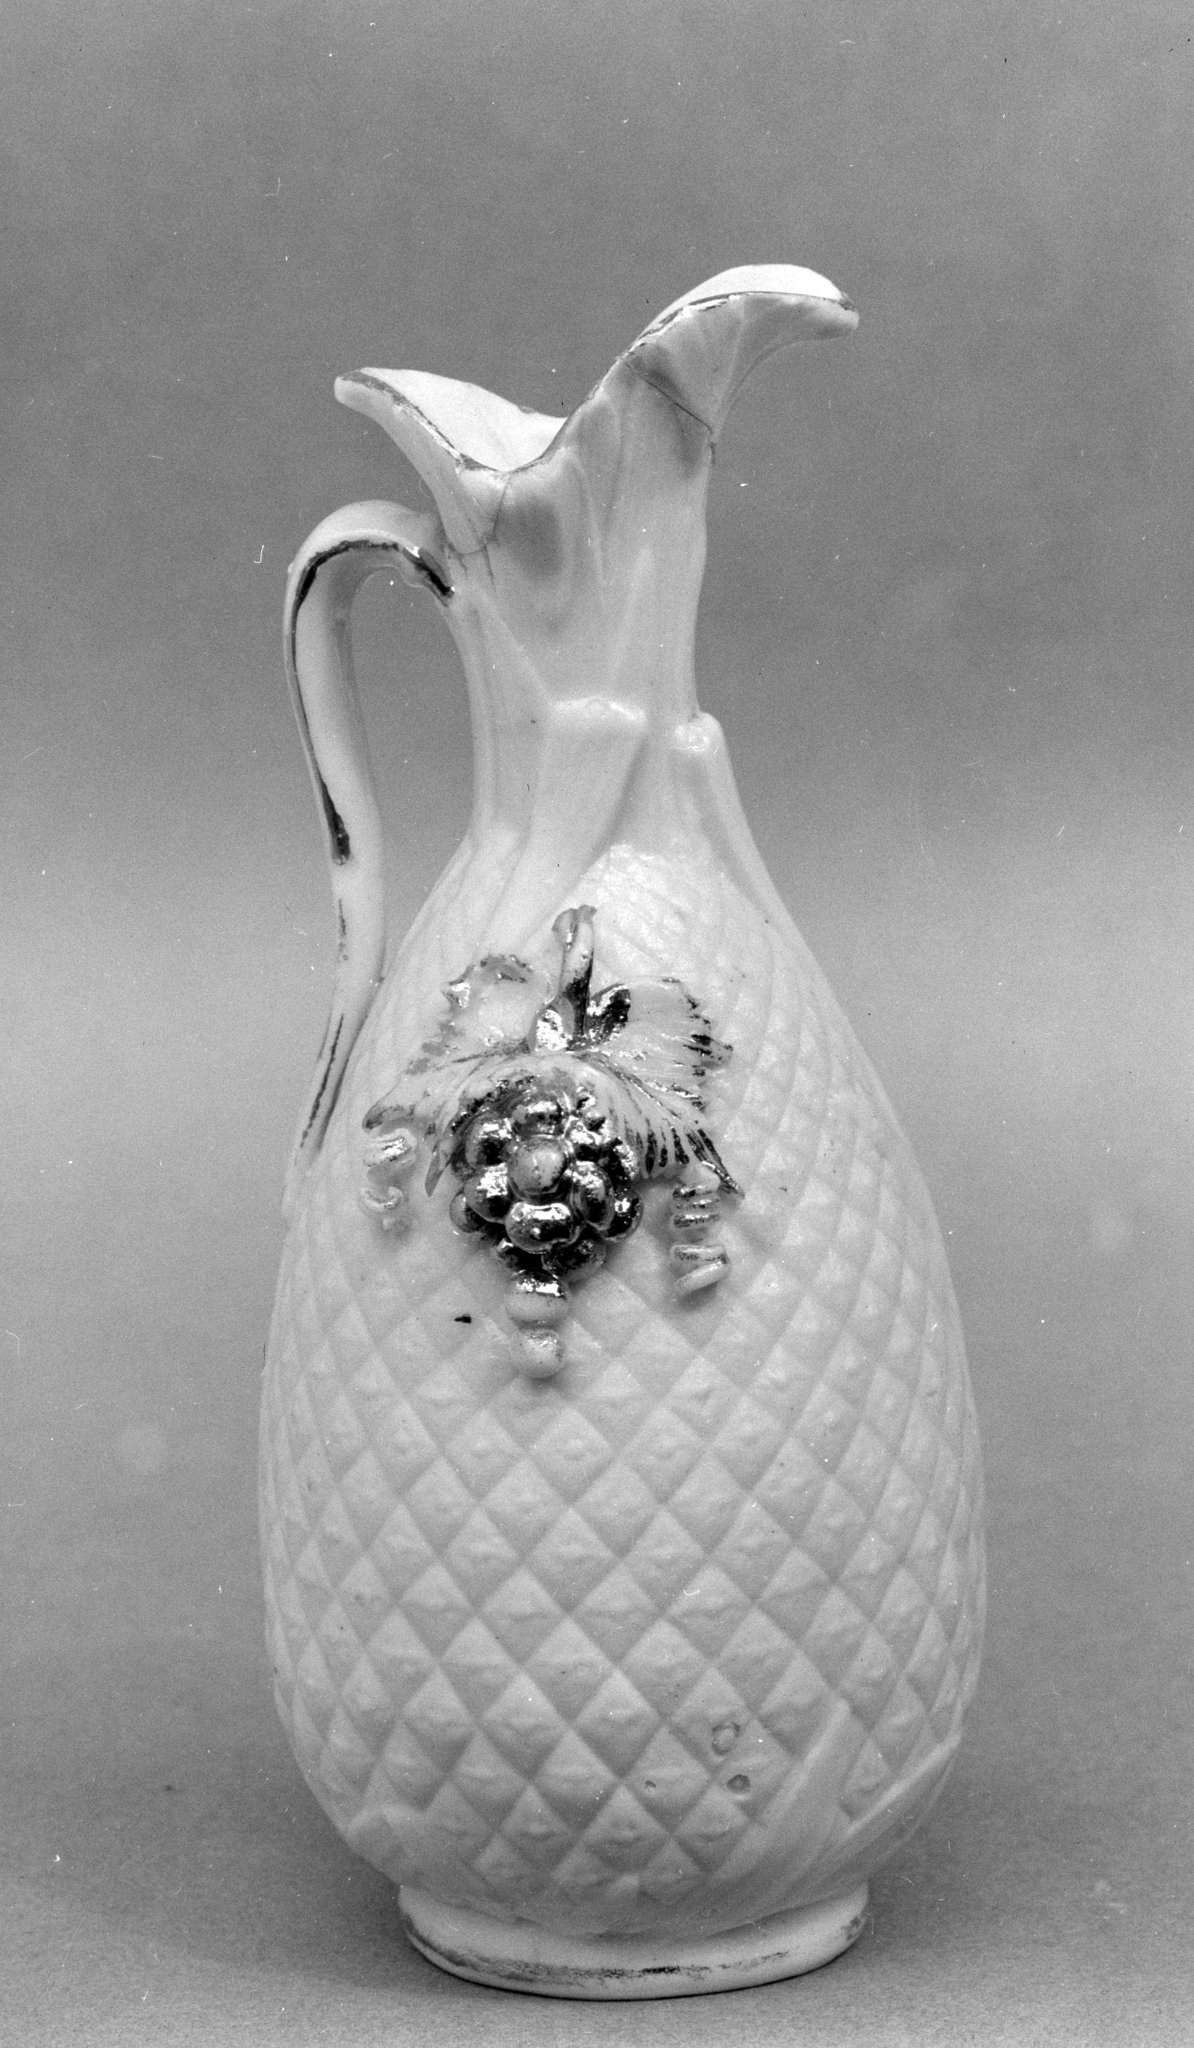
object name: ewer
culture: american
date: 1830-1870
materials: porcelain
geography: united states